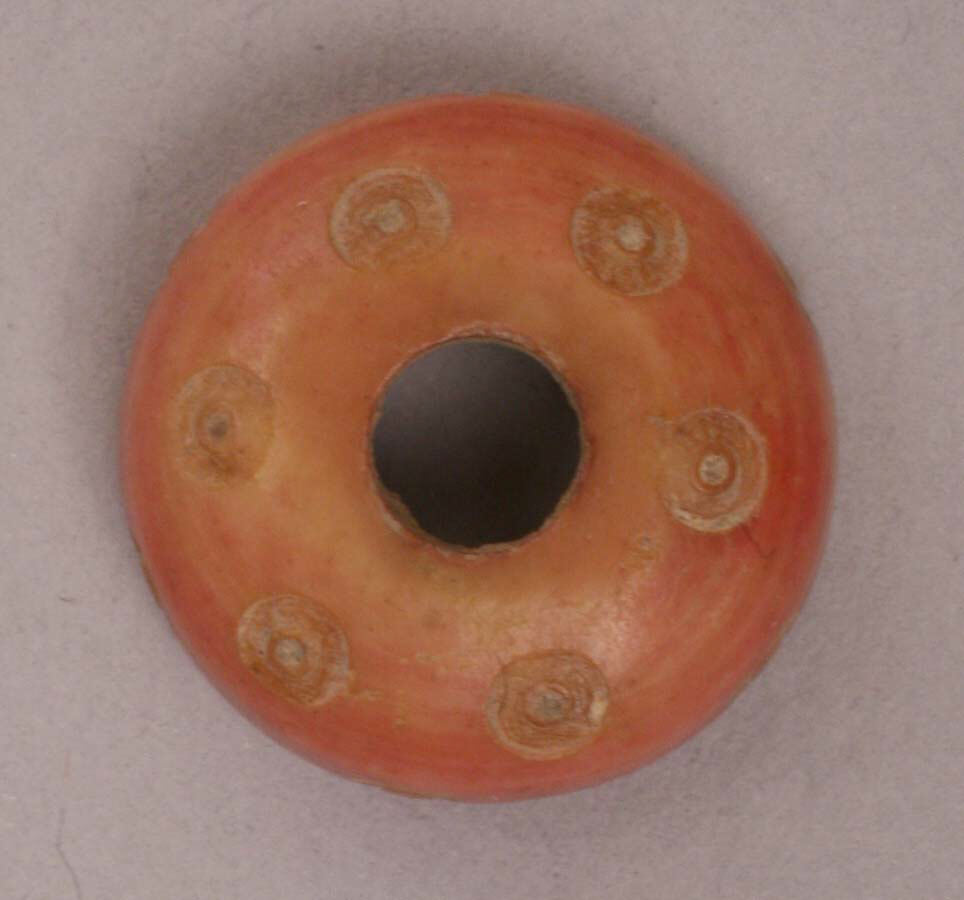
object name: button or bead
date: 801-1000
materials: bone, paint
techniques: incising, inlay, tinting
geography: iran